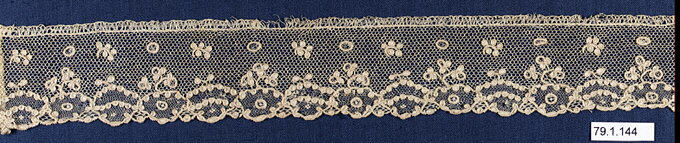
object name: strip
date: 1701-1800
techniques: lace